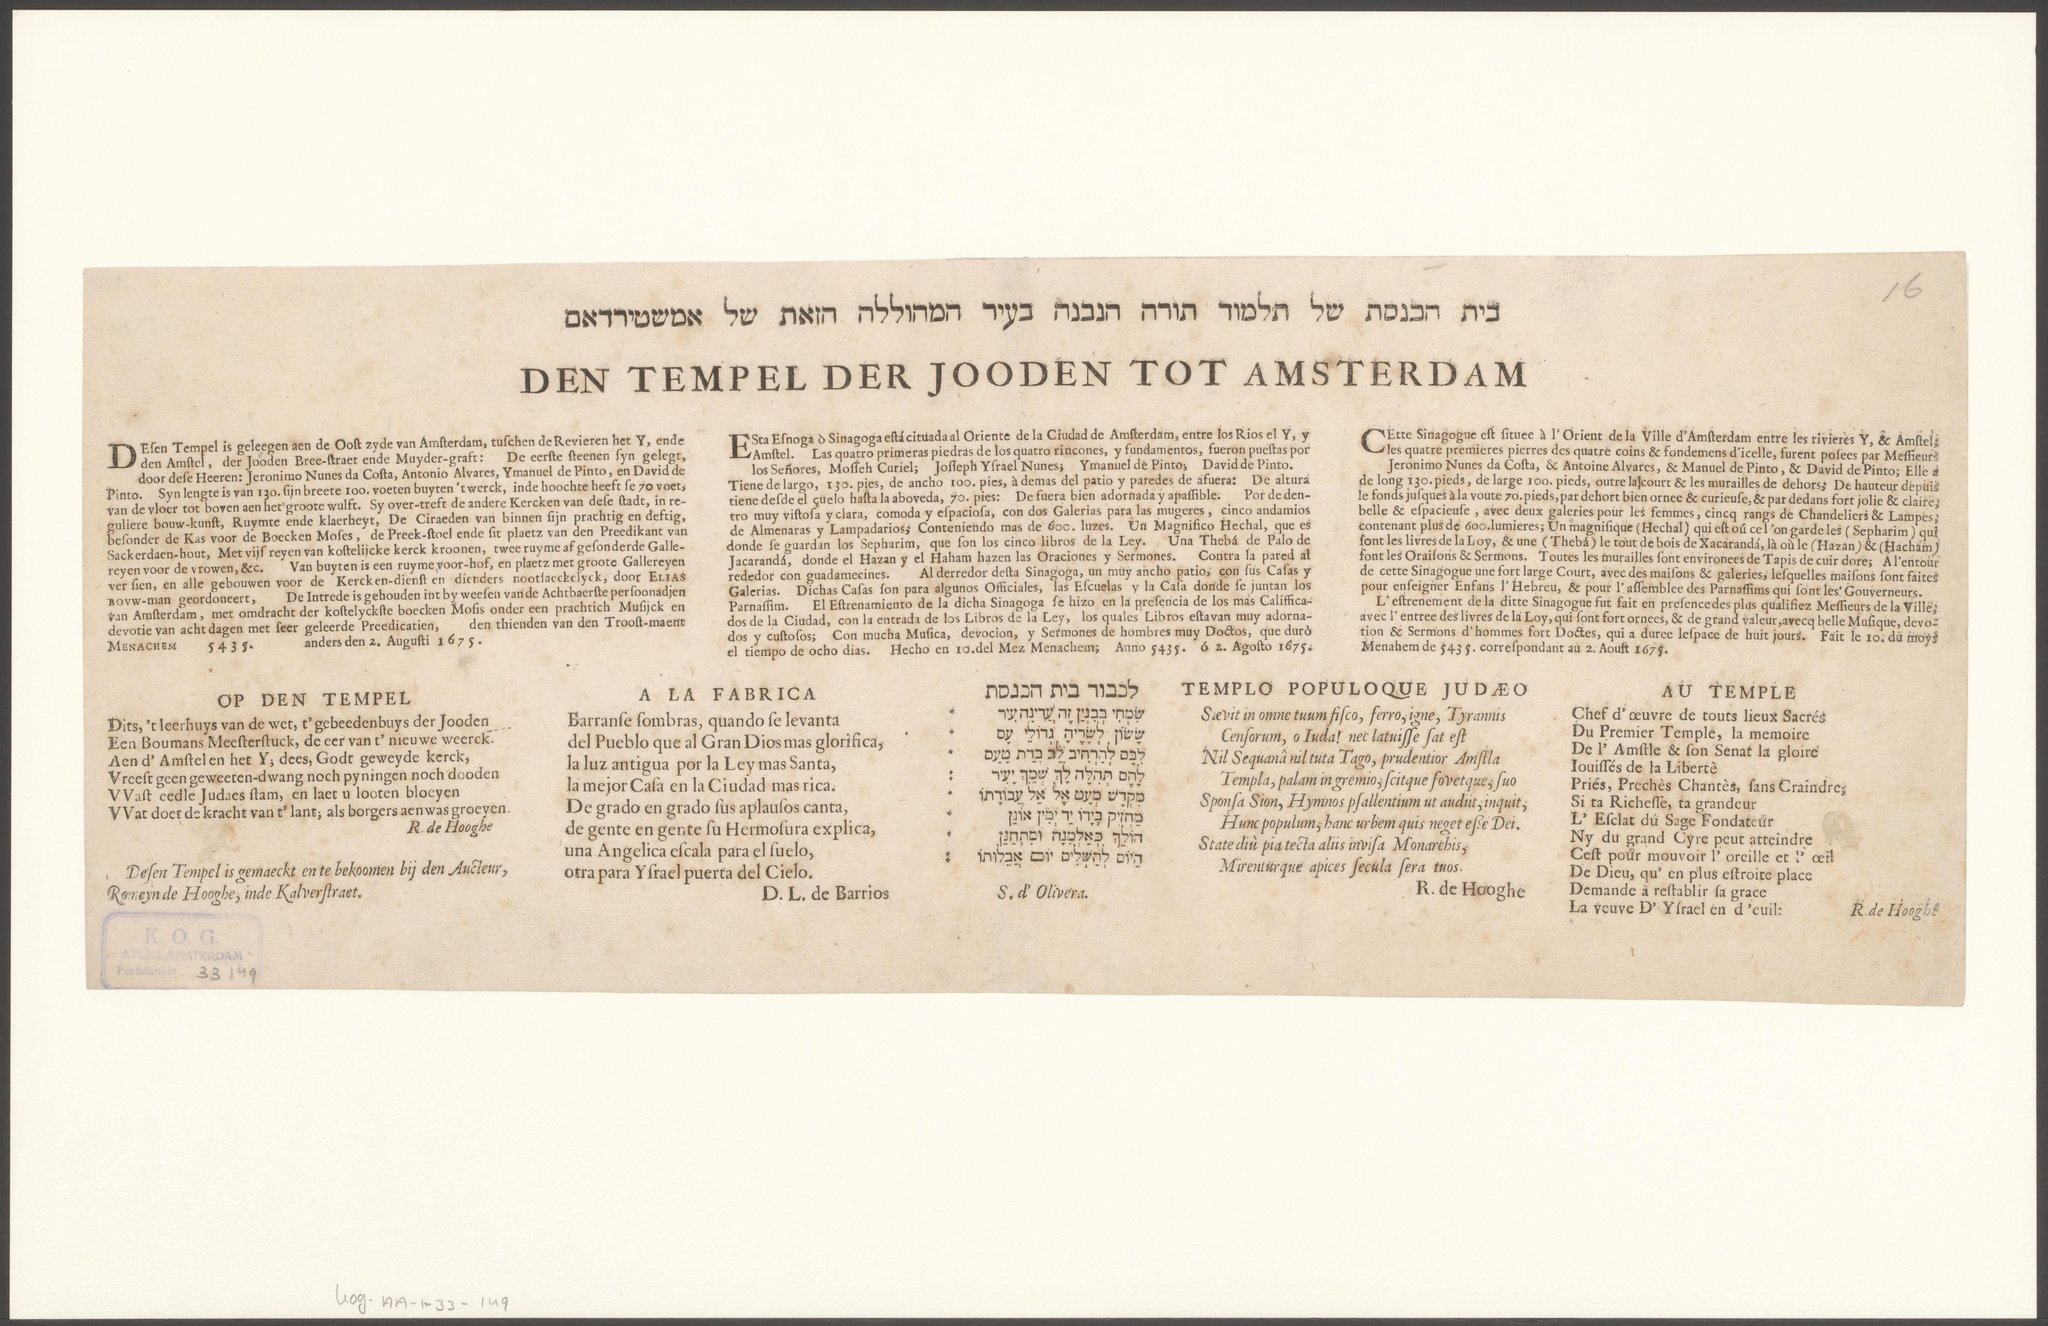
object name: text sheet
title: Tekstblad bij een prent van het interieur van de Portugese Synagoge te Amsterdam tijdens de inwijding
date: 1675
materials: paper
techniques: letterpress printing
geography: amsterdam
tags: the synagogue (as building and place of worship ~ jewish religion), street (+ city(-scape) with figures, staffage)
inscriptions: collector's mark: Lugt 1641b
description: Tekstblad bij de prent van het interieur van de Portugese Synagoge te Amsterdam tijdens de inwijding op 2 augustus 1675. Blad met tekst in drie kolommen in het Nederlands, Portugees en Frans en vijf verzen in het Nederlands, Portugees, Hebreeuws, Latijn en Frans. Onderwerpsrubriek binnen de Atlas Amsterdam: Kerkwezen: Gebouwen diverse gemeenten: Portugees-Israëlitische Gemeente + rabbijnen.